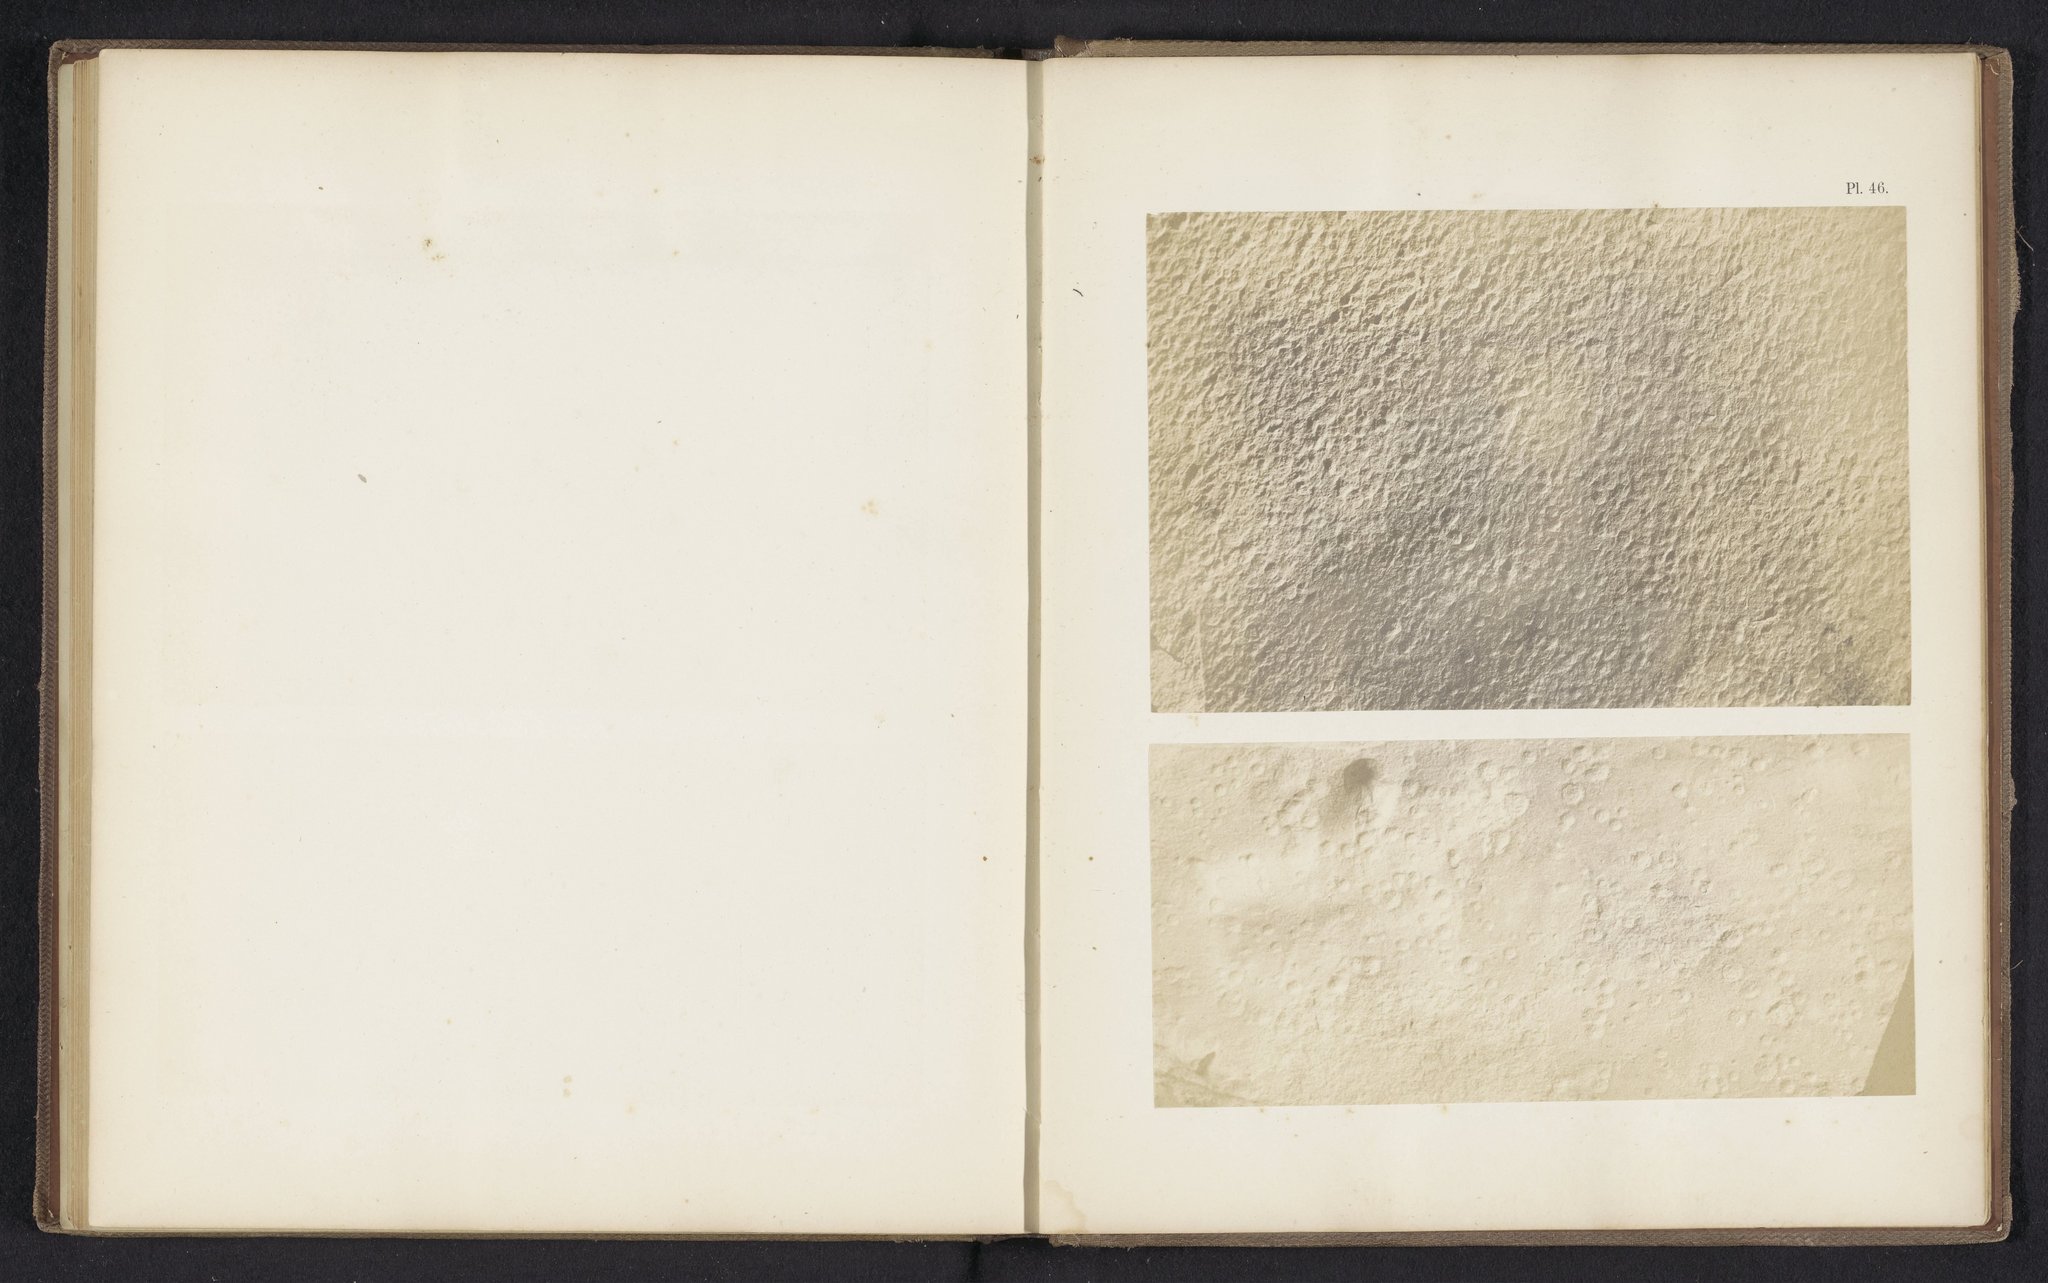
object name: page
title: Twee afbeeldingen van afdrukken van regendruppels op zandsteen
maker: Anonymous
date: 1850-1861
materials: paper, photographic support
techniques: salted paper print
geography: united states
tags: foot-print, track, rain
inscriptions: number: ‘Pl. 46.’